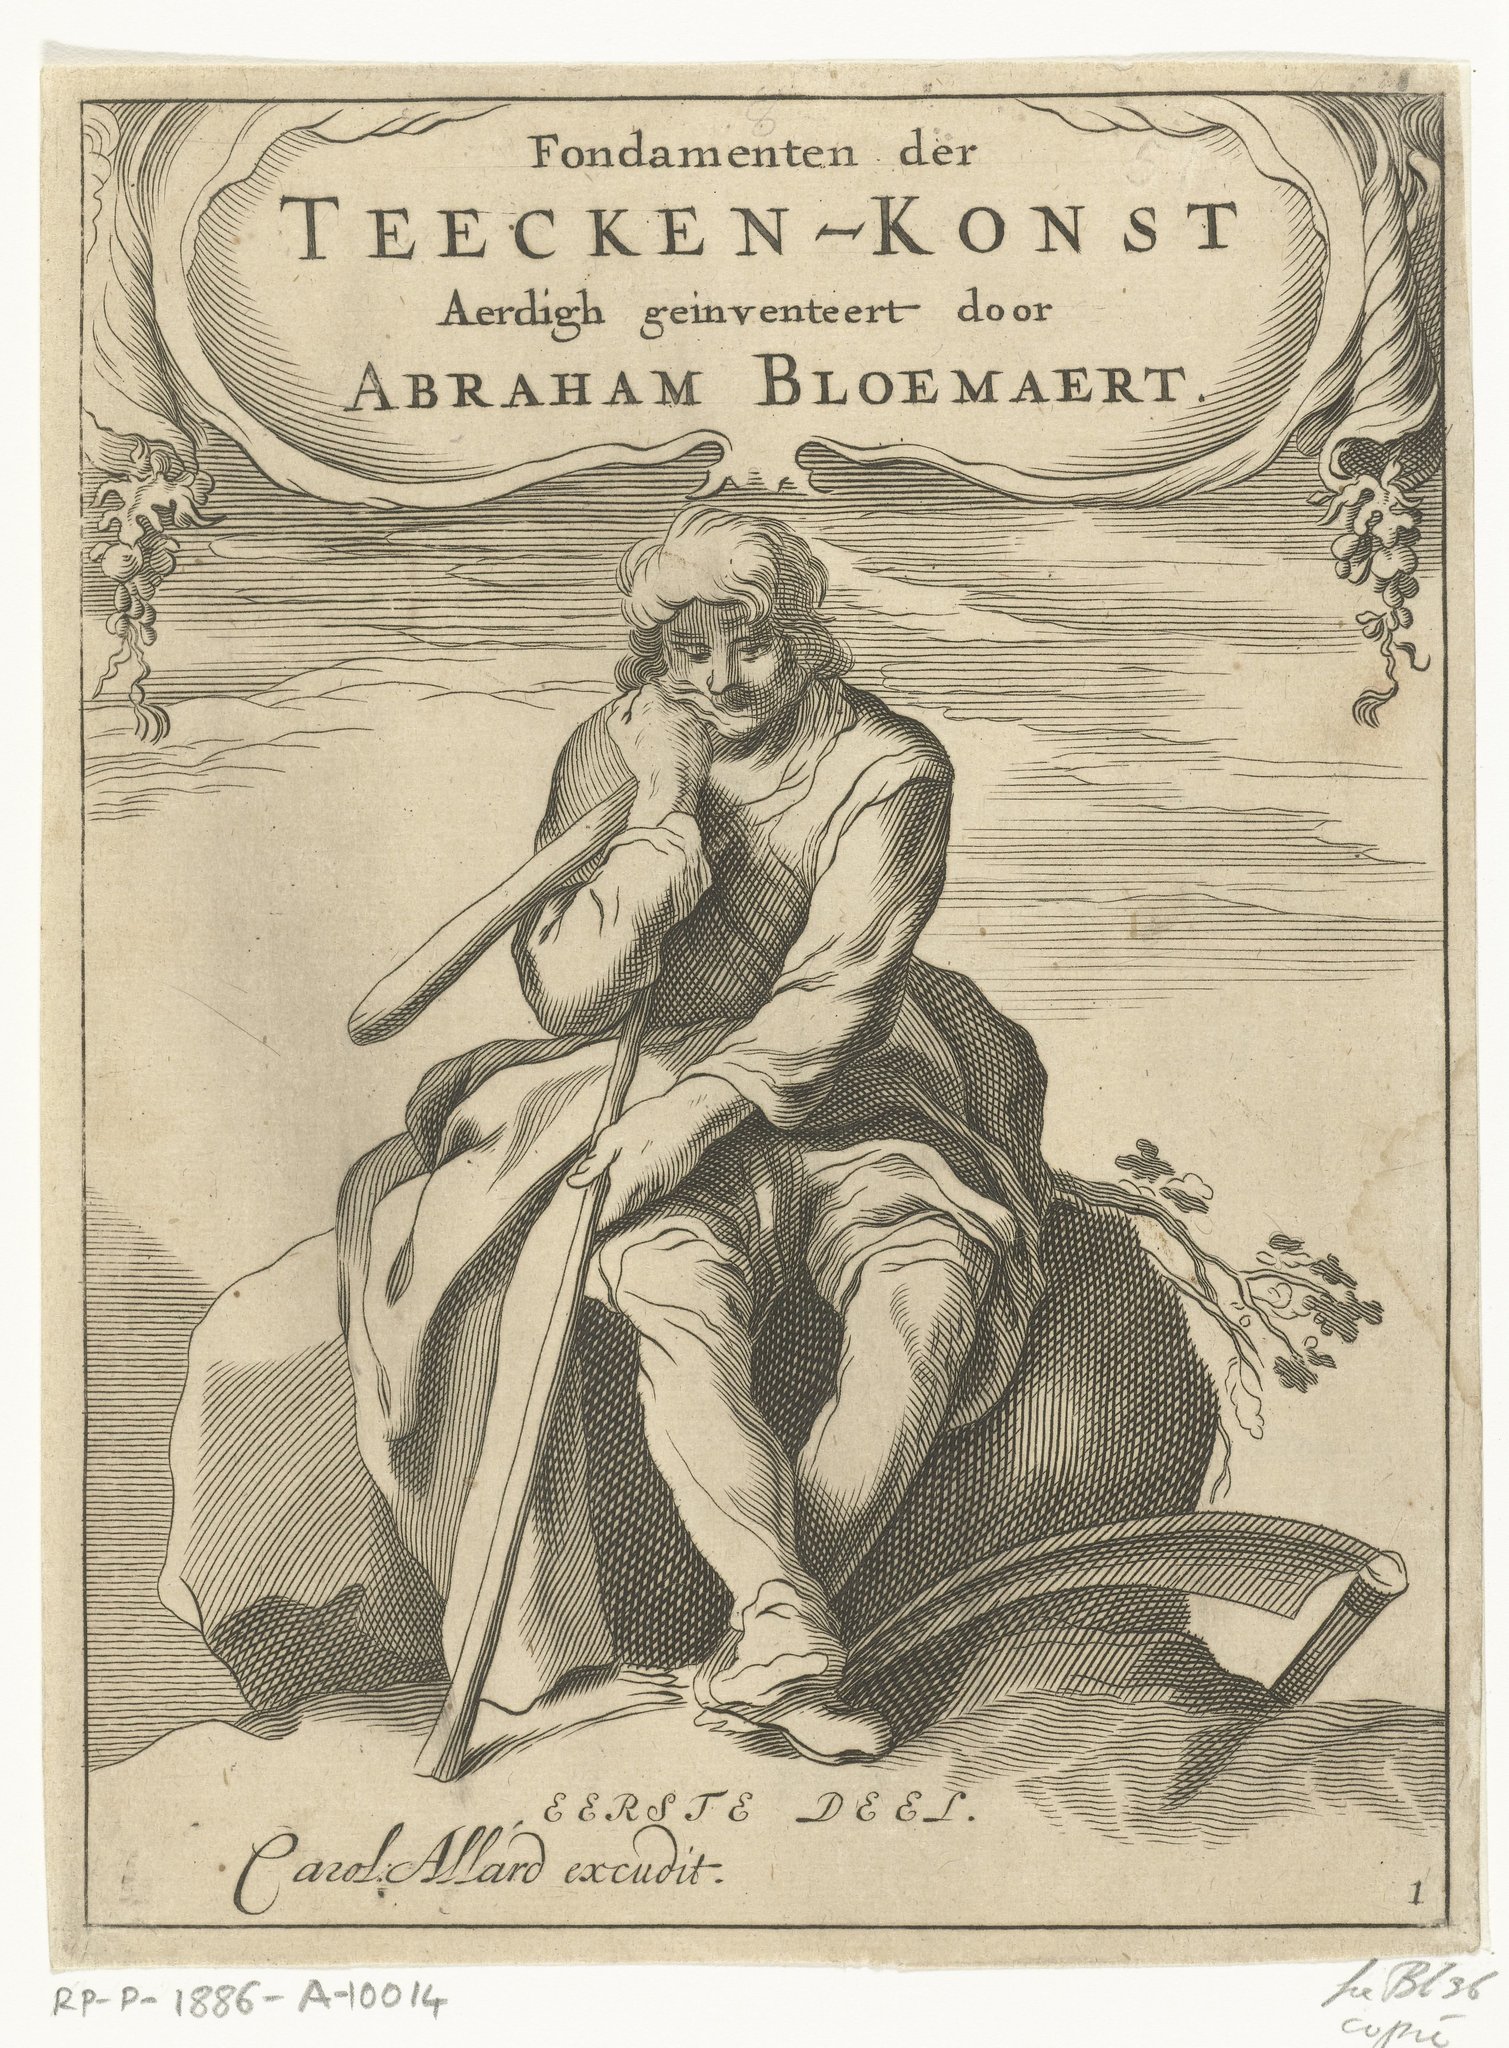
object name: titelblad, titelpagina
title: Titelpagina voor Abraham Bloemaert, Fondamenten der Teecken-konst, eerste deel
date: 1709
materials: paper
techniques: engraving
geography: amsterdam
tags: title-page, crafts and industries (+ harvesting ~ agricultural processes)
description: Titelpagina voor deel 1 van een editie van kopieën naar de gravures door Frederik Bloemaert uit de Visscher editie van het "Tekenboek" van Abraham Bloemaert : A. Bloemaert, Fondamenten der Teecken-konst, [Amsterdam], Carel Allard, [1709]